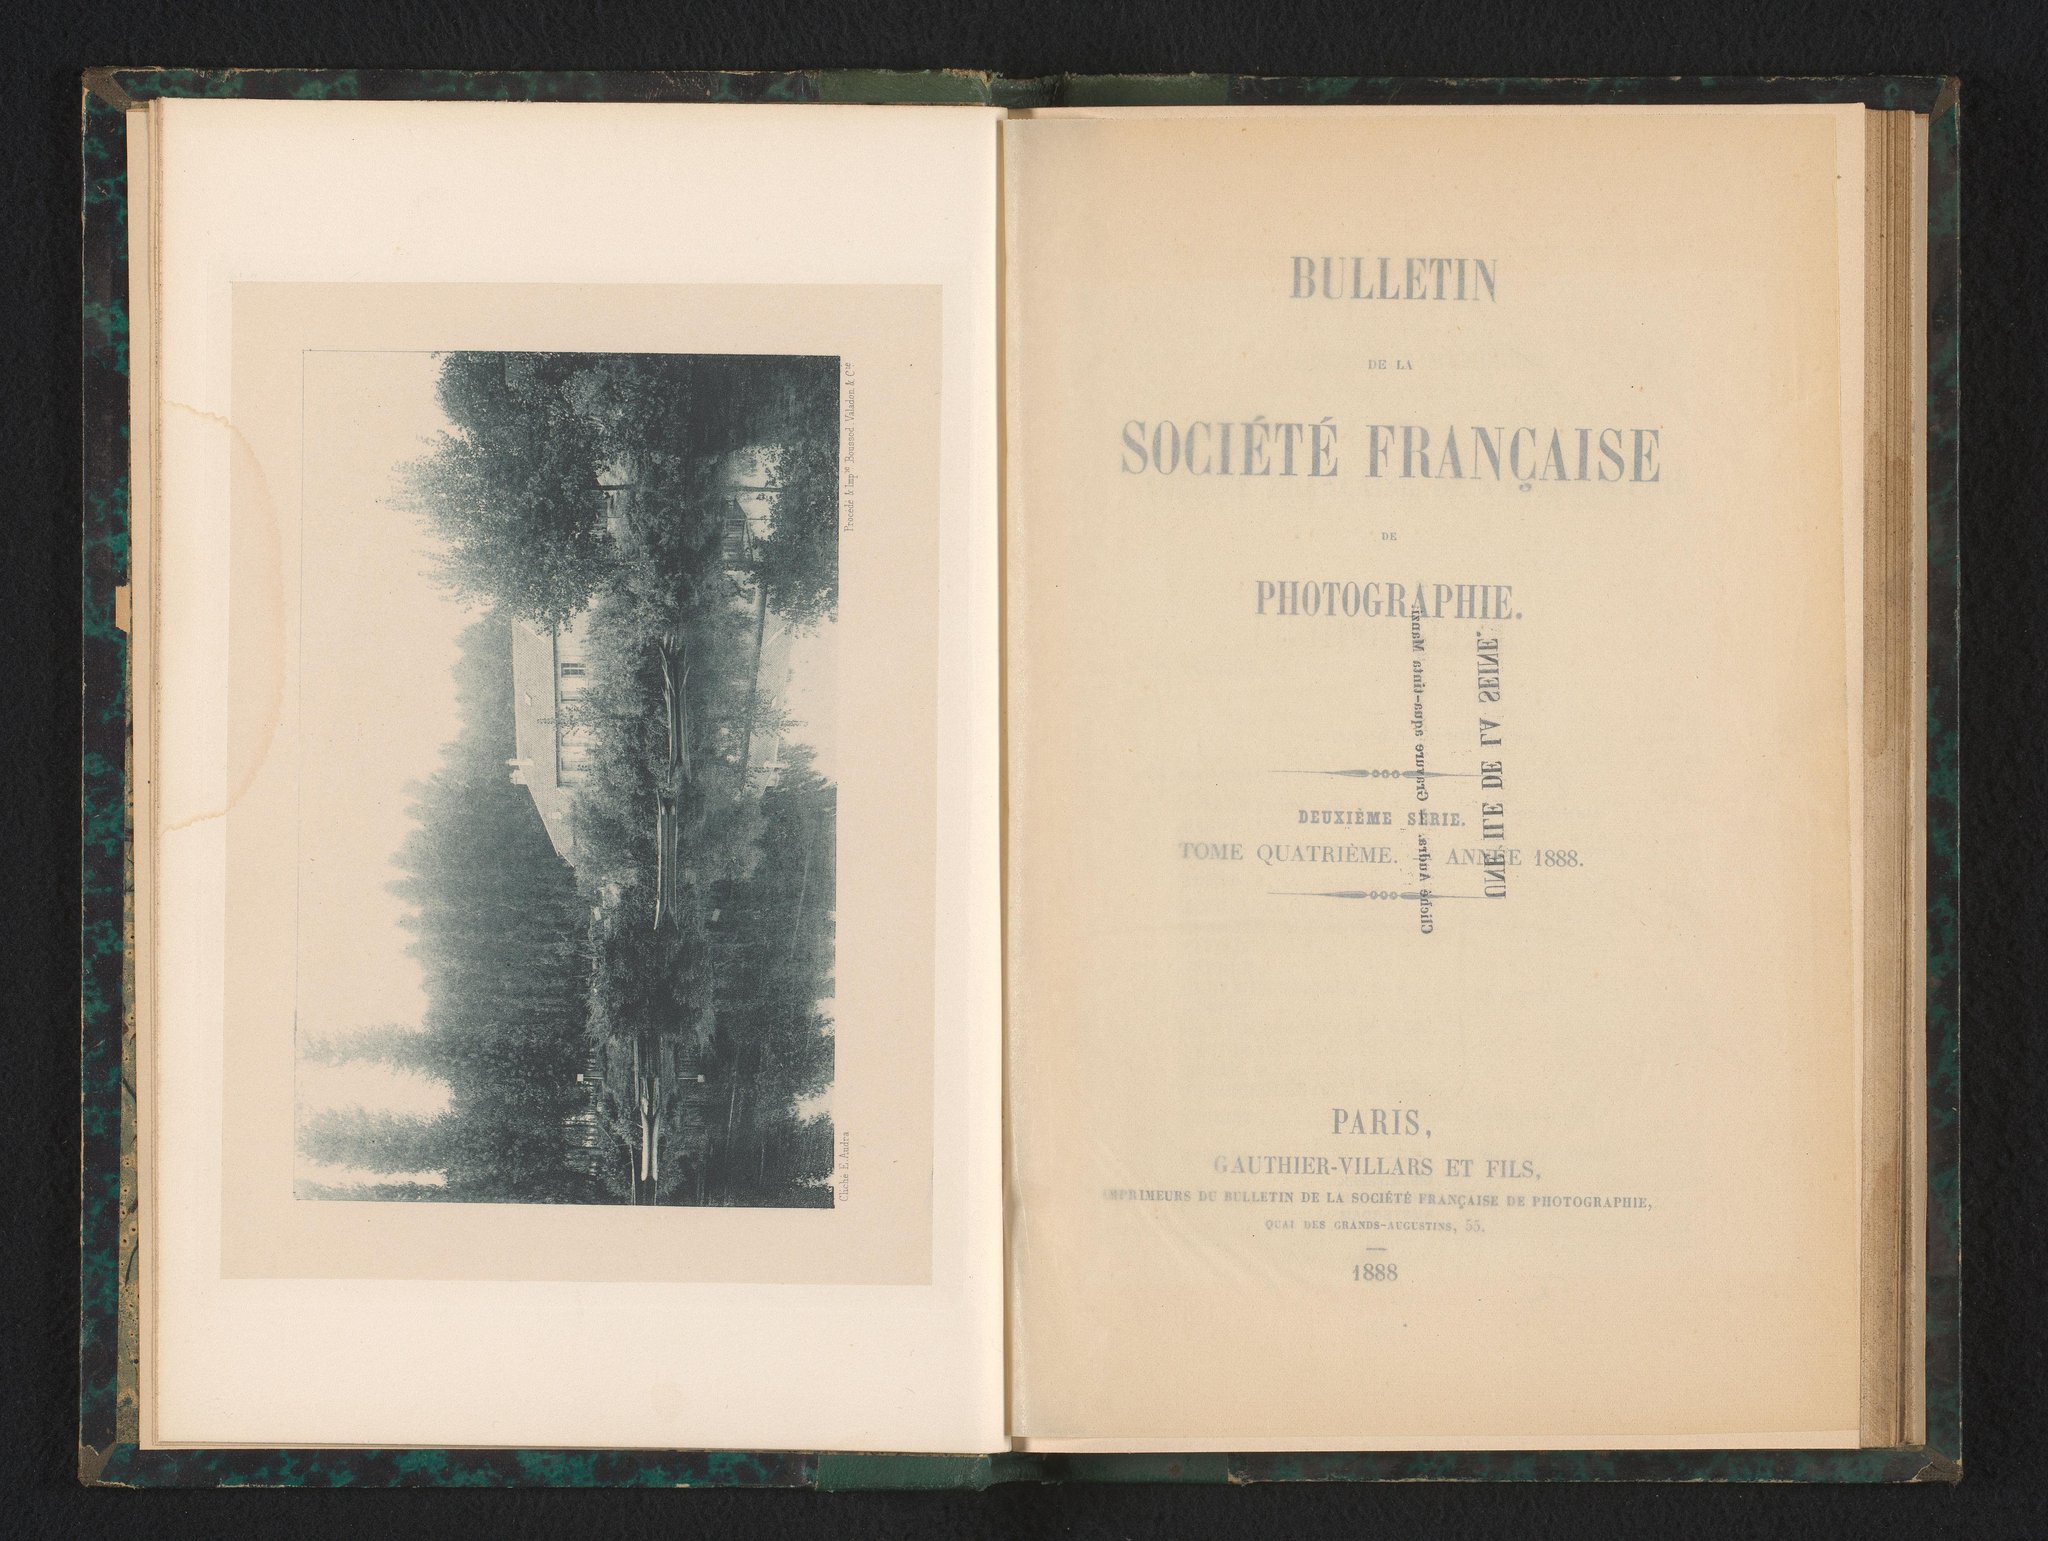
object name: page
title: Gezicht op een huis op een eiland in de Seine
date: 1883-1888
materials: paper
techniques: photolithography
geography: paris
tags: island, river, rural housing, e.g. country-house, villa, cottage